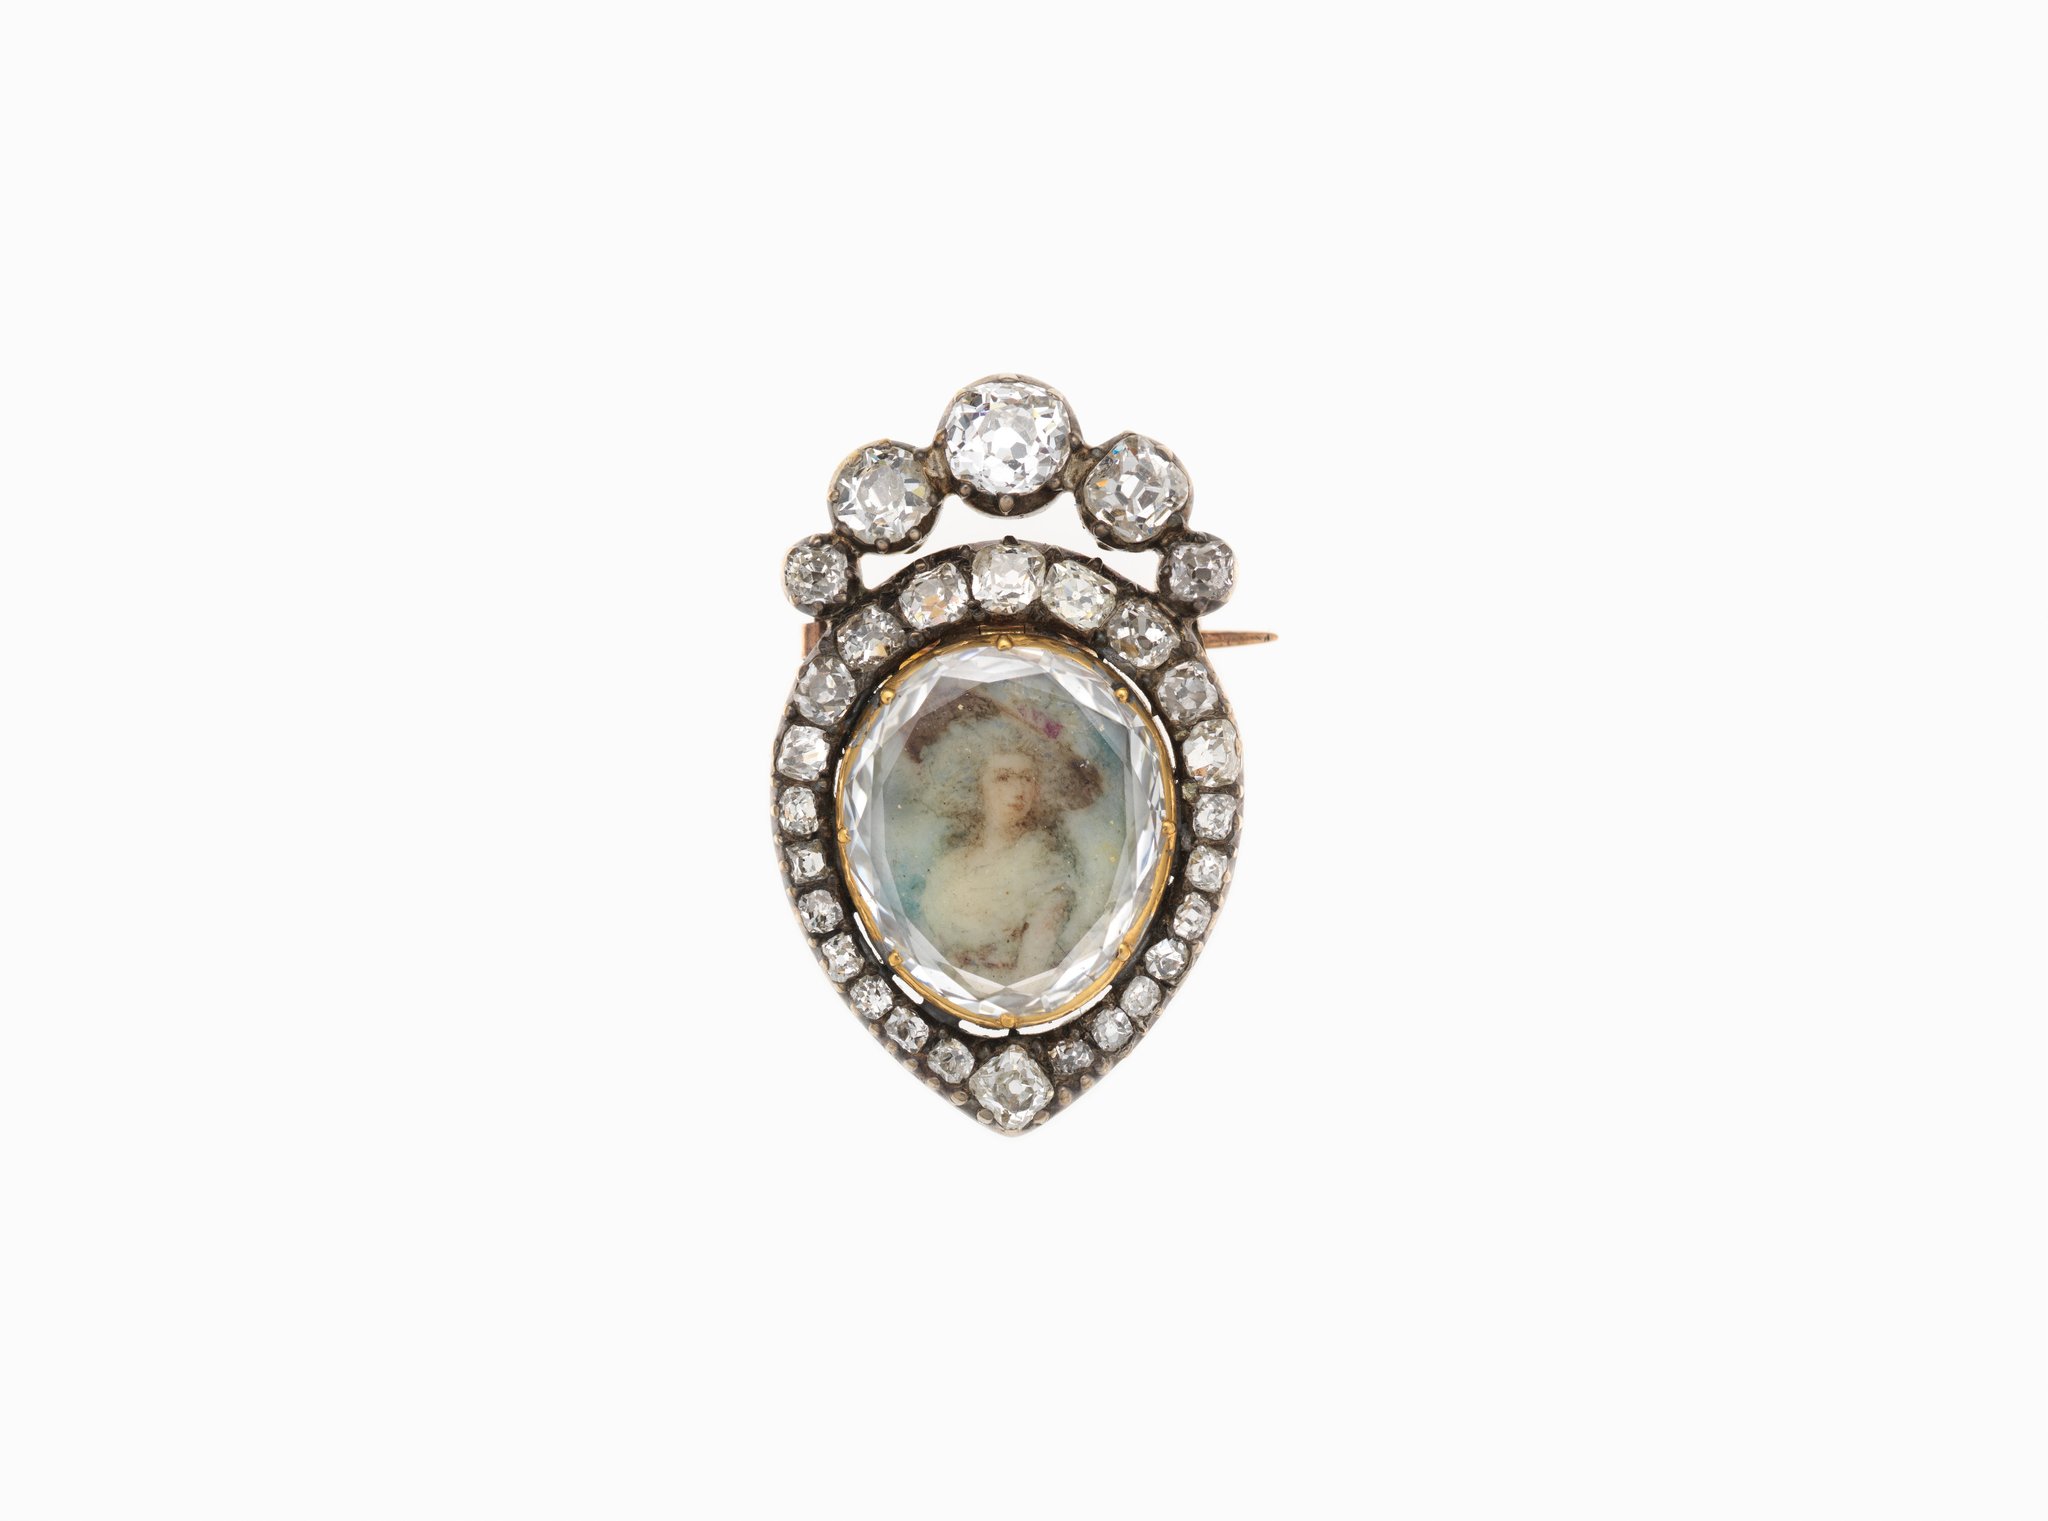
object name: brooch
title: Duchess of Devonshire Portrait Diamond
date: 1801-1900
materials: diamond, ivory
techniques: painting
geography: england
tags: portraits,women